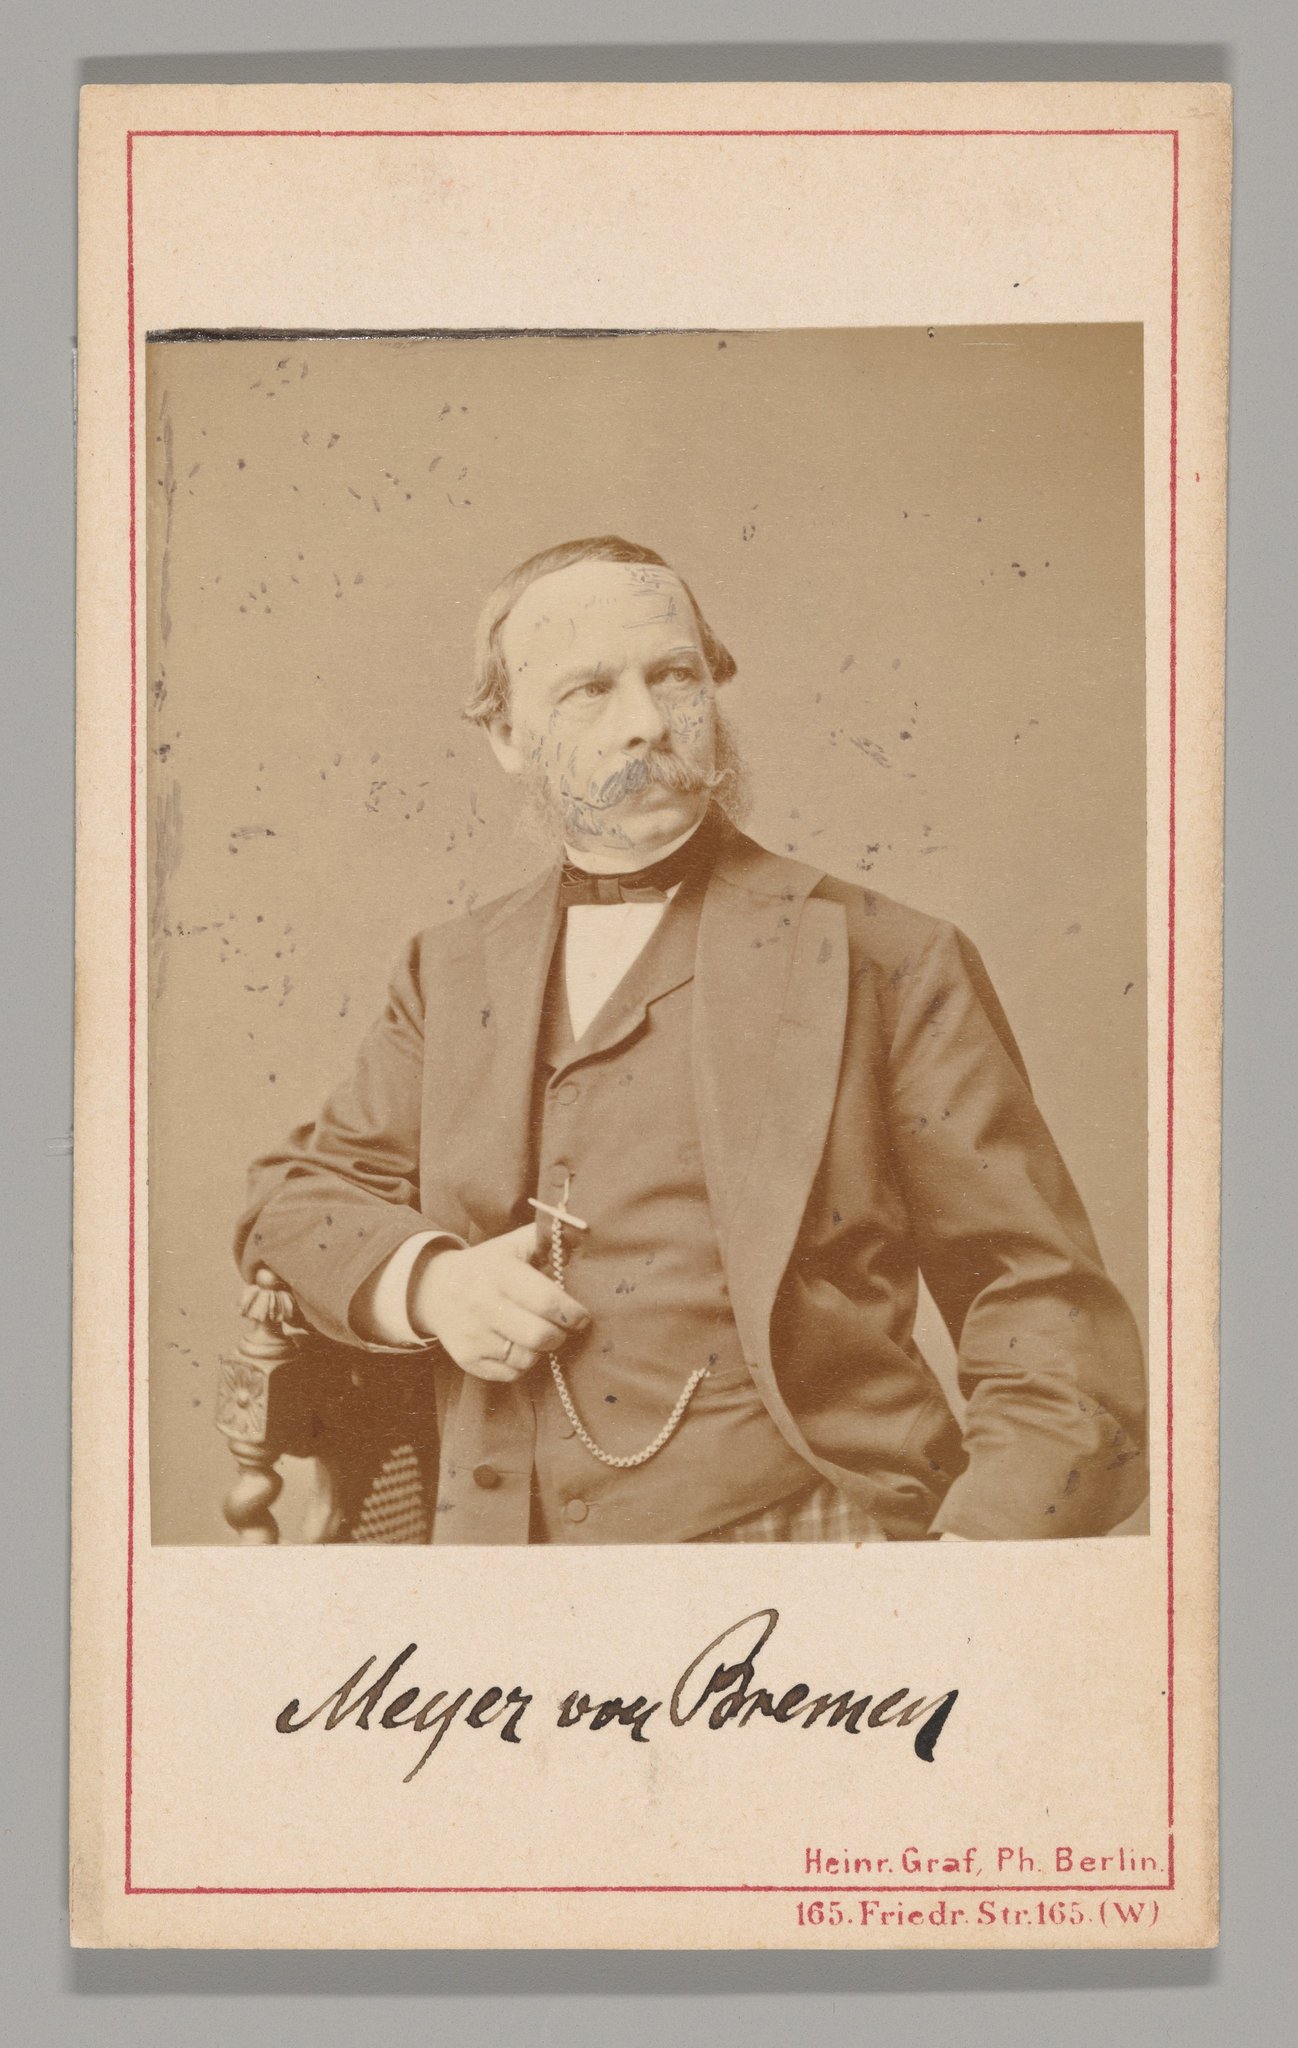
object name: carte de visite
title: [Meyer George von Bremen]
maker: heinrich graf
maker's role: artist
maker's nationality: german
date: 1860-1869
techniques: albumen silver print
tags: men,portraits